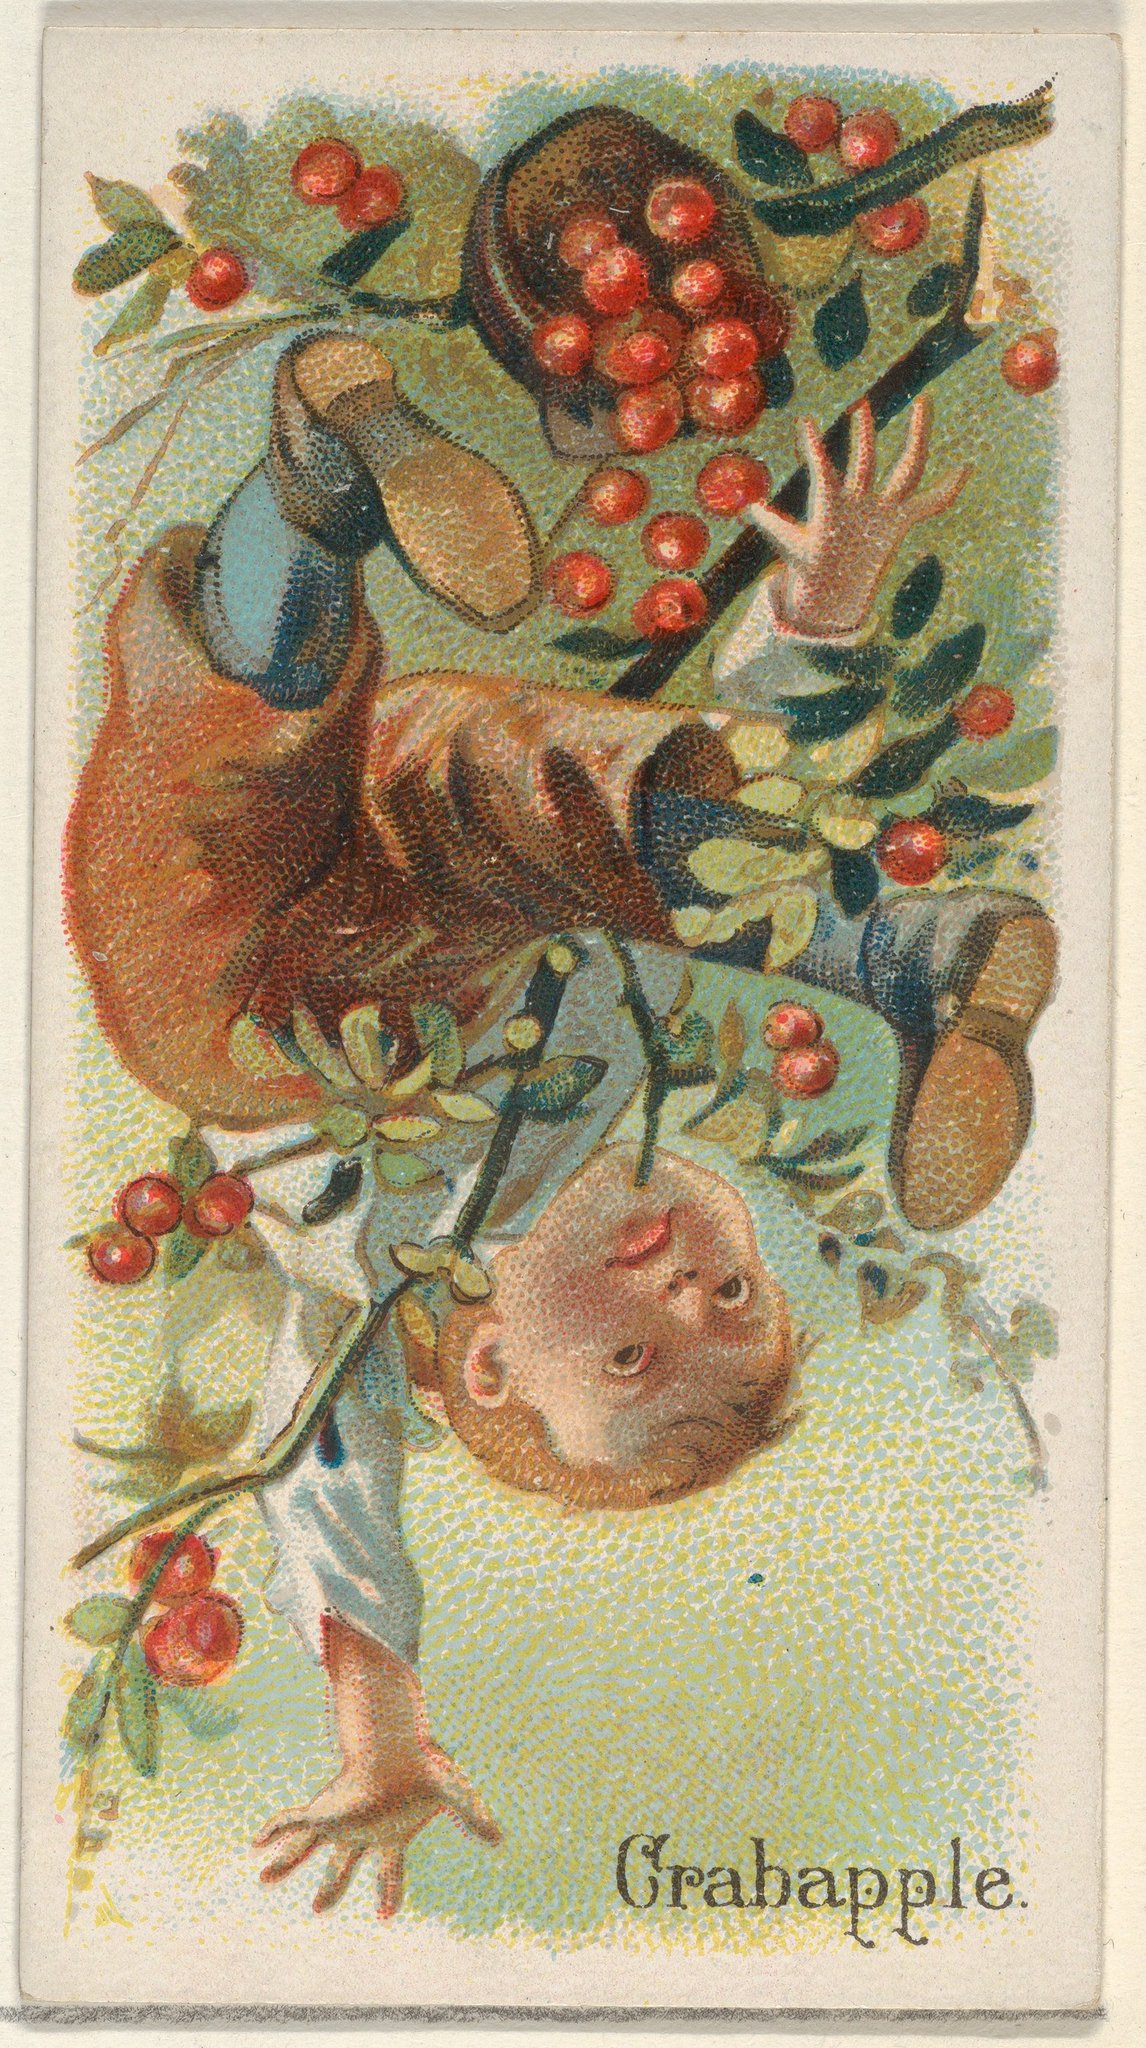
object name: print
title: Crabapple, from the Fruits series (N12) for Allen & Ginter Cigarettes Brands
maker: allen & ginter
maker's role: publisher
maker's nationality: american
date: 1891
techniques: color lithograph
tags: fruit,boys,leaves